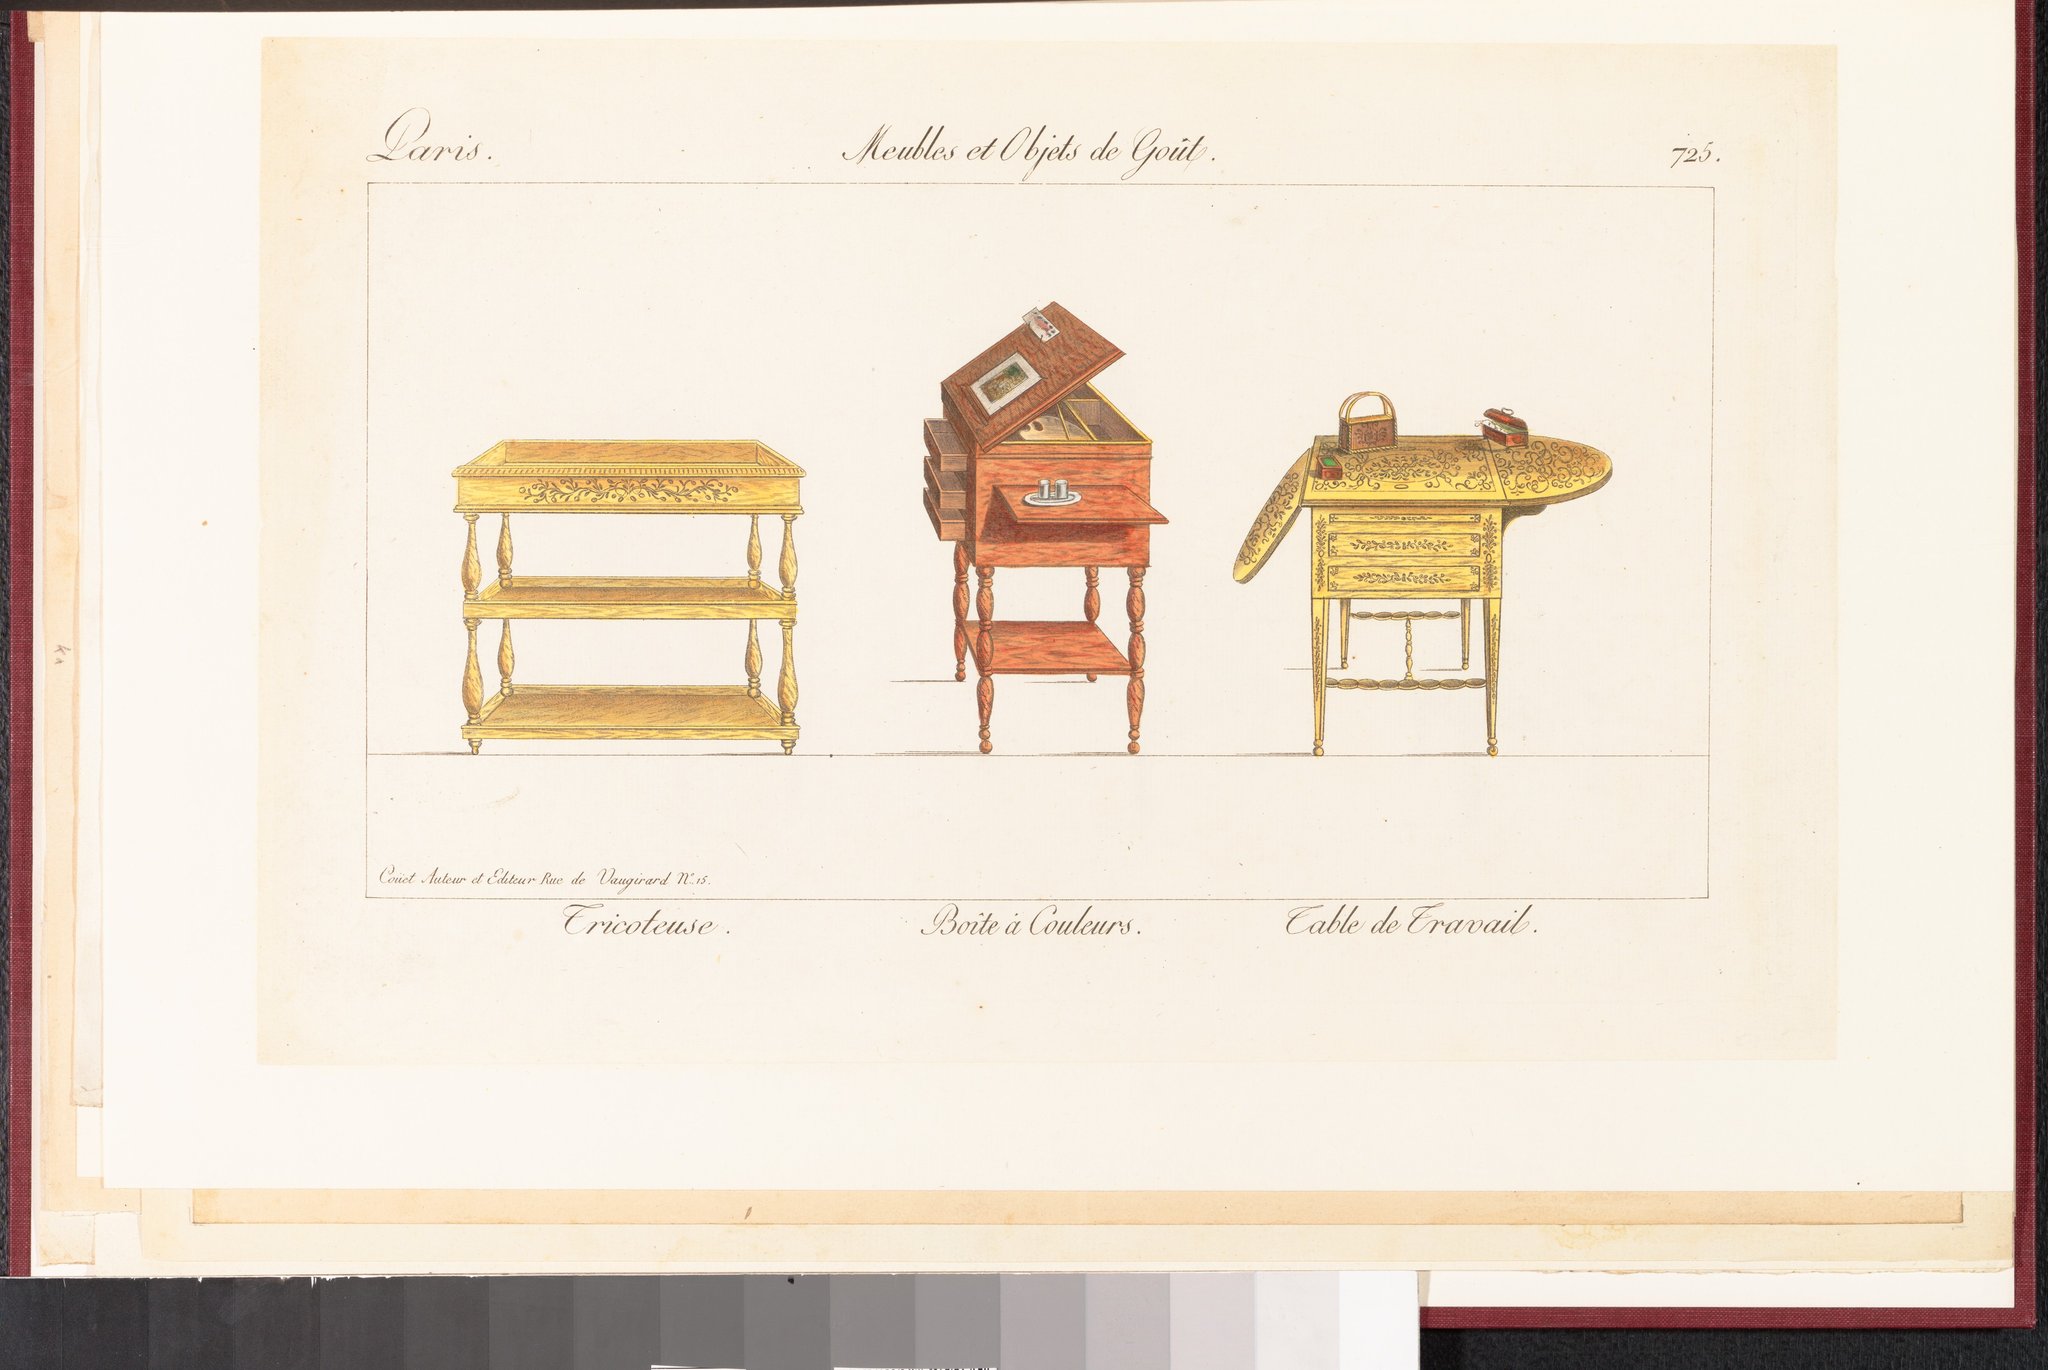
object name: book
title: Meubles et Objets de Goût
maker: pierre de la mésangère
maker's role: editor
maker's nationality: french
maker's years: 1761-1831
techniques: engraving, hand coloring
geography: france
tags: furniture